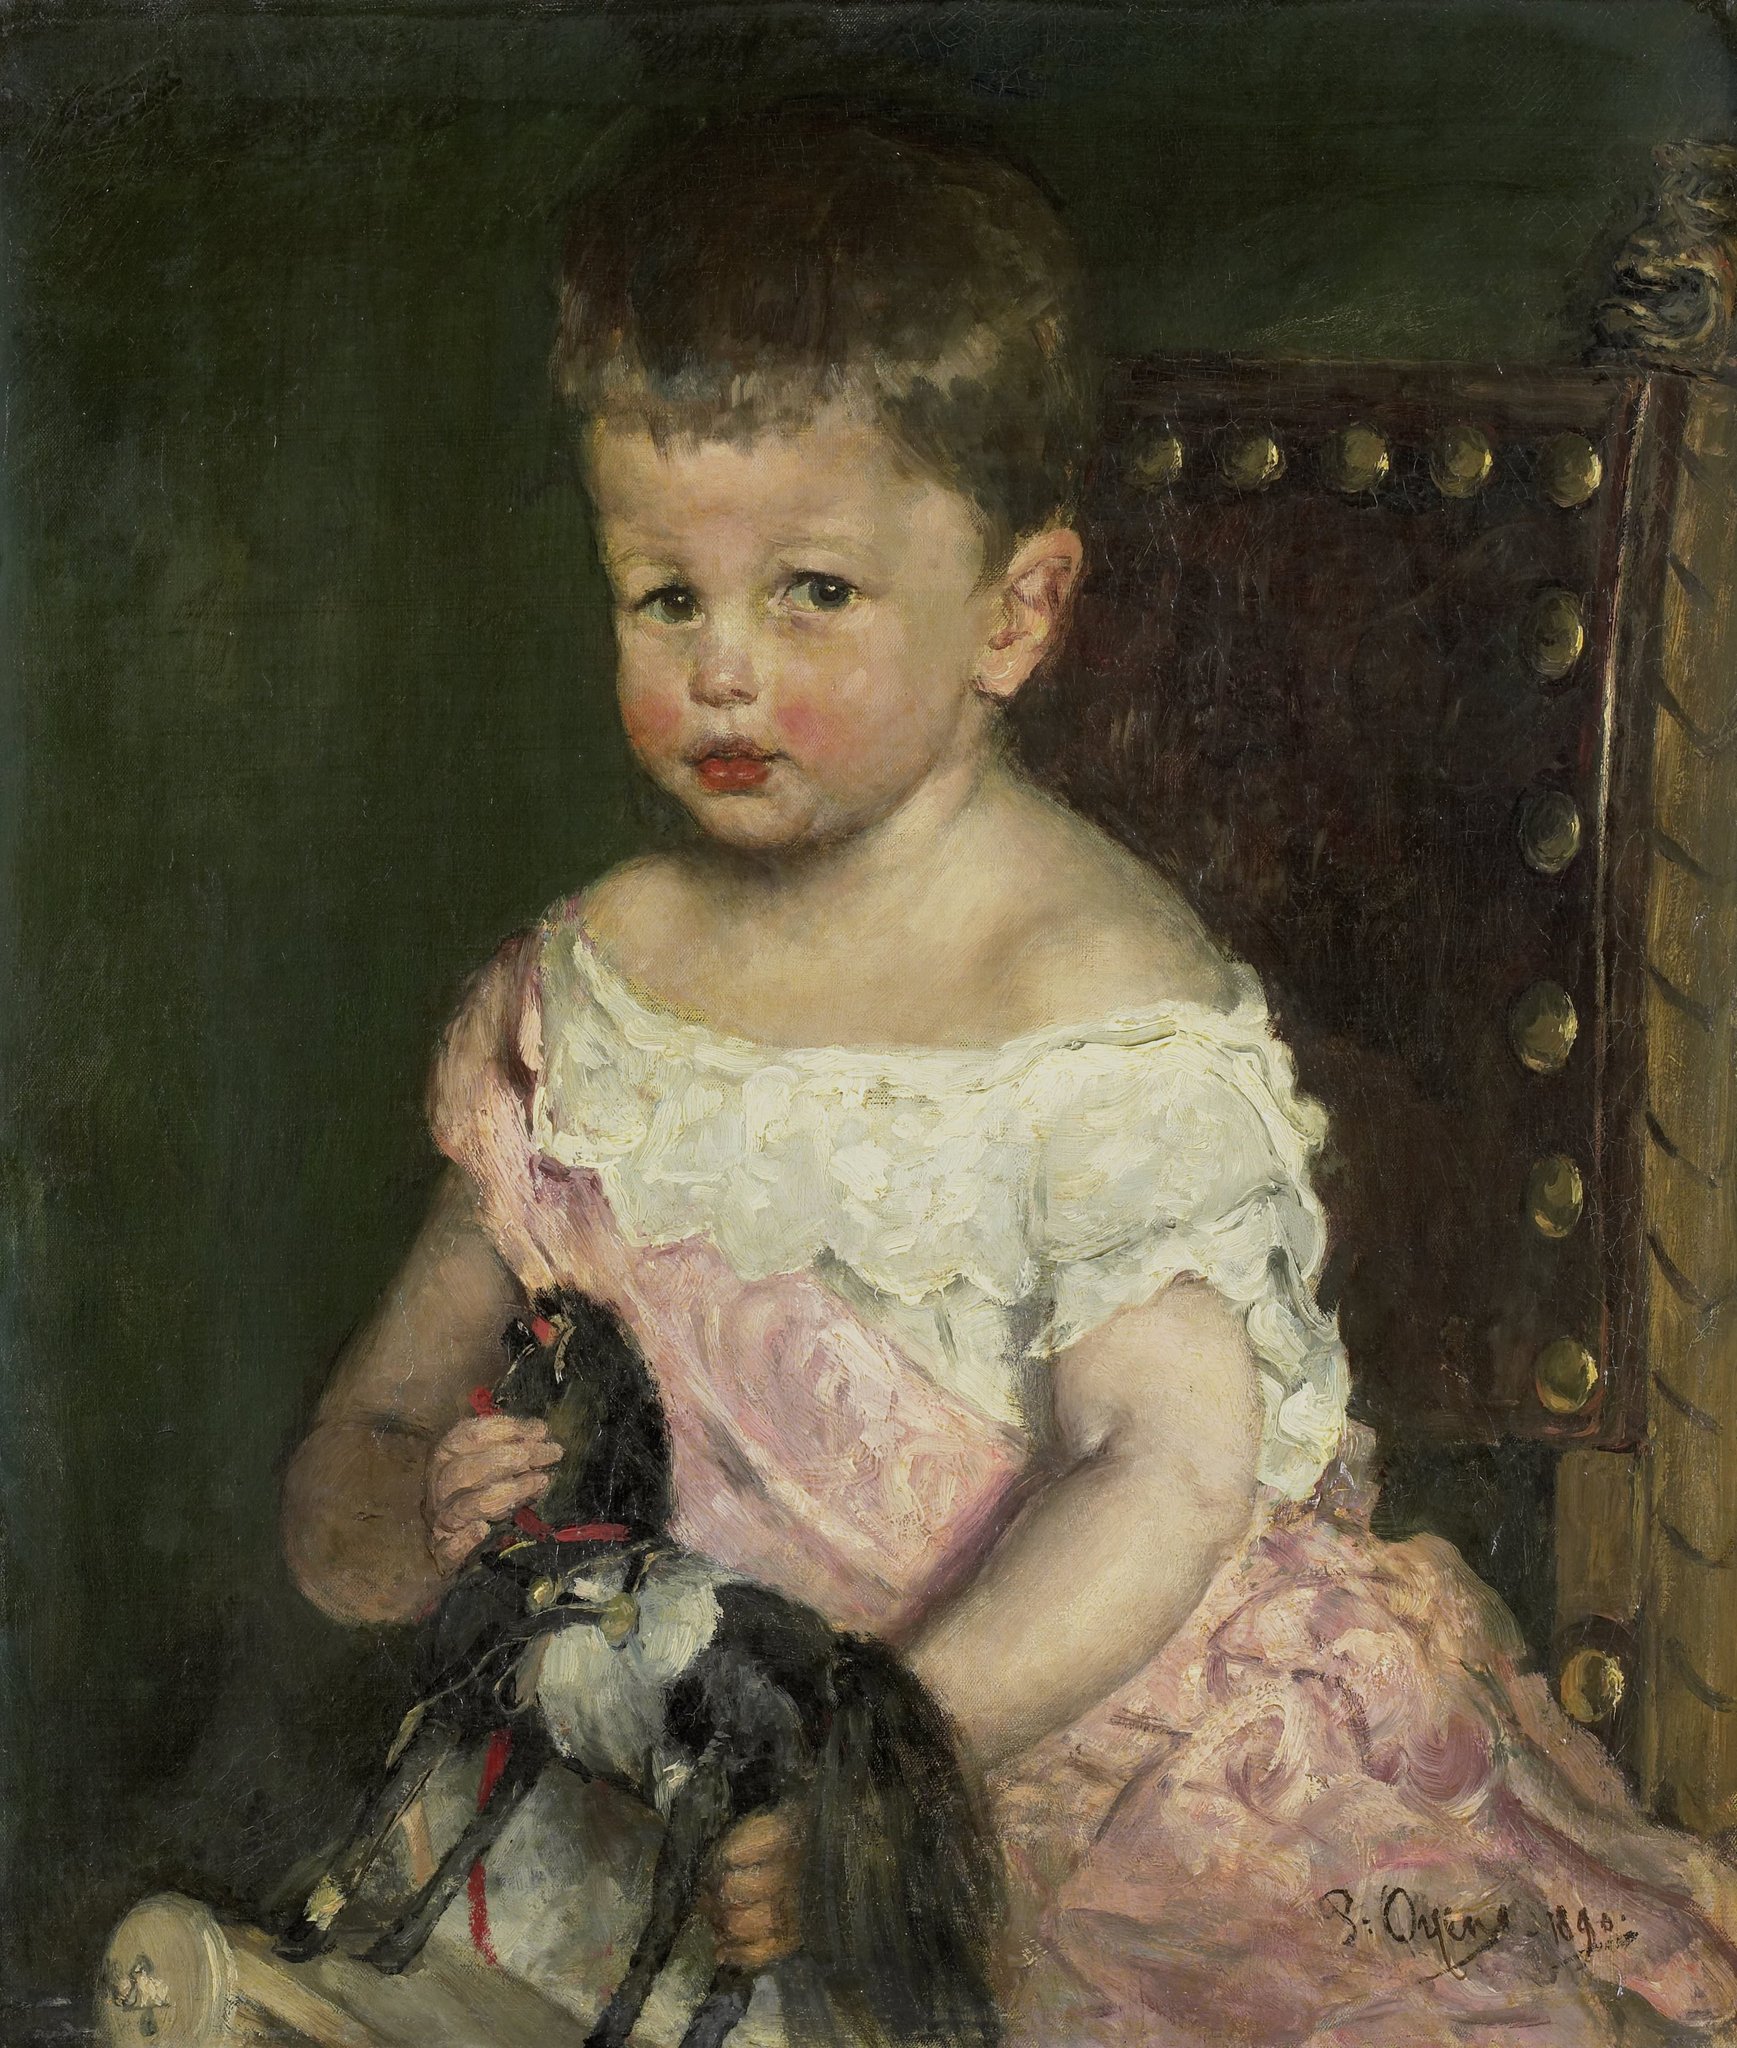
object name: painting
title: Hendrik Waller (1887-1951) op driejarige leeftijd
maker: pieter oyens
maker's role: draughtsman, painter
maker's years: 1842-1894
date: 1890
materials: canvas, oil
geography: netherlands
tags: (playing with) toy animals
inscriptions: signature and date: ‘P: Oyens f 1890’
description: Portret van Hendrik Waller (1887-1951) op driejarige leeftijd. Kniestuk, zittende in een wit jurkje op een stoel, in de handen een speelgoedpaardje op wielen.